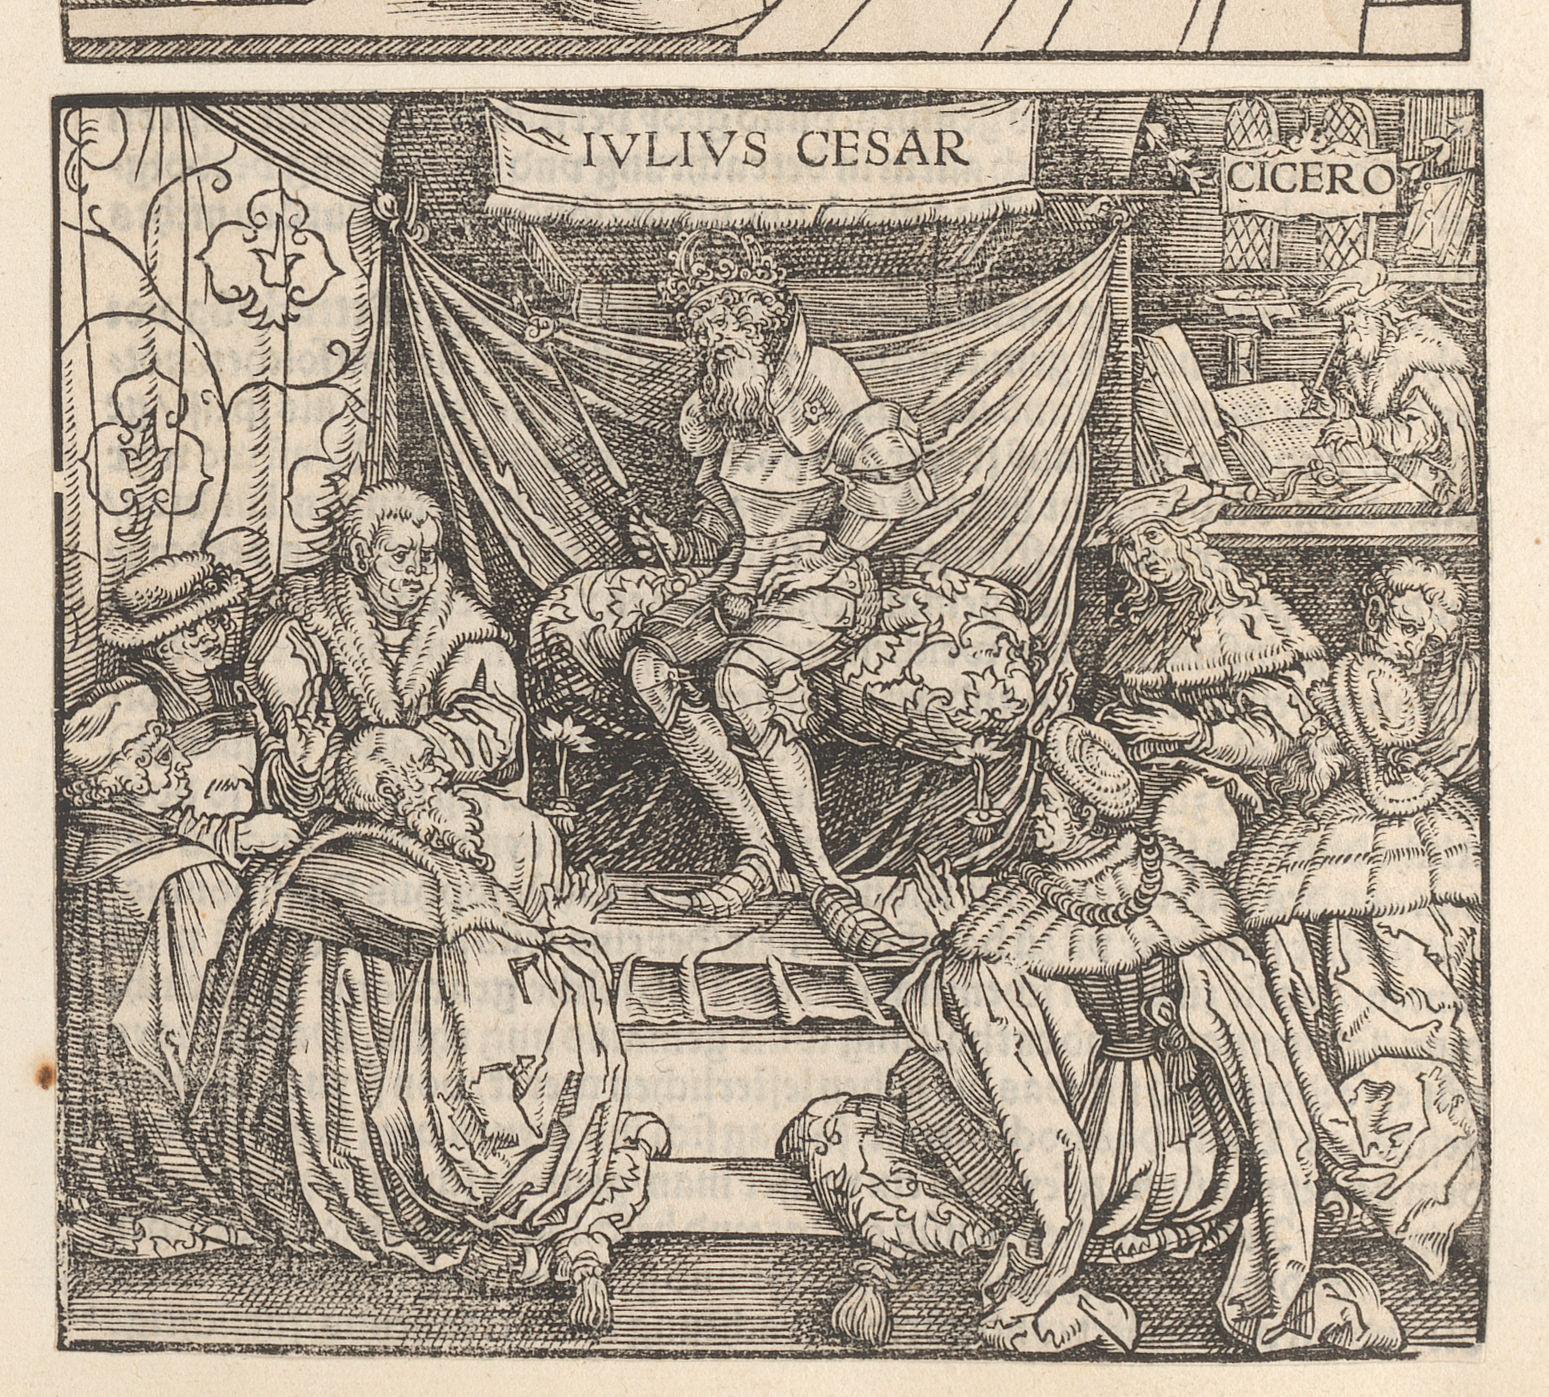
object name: print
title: Julius Caesar in een raadsvergadering en Cicero schrijvend achteraan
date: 1514-1531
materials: paper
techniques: letterpress printing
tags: (story of) cicero, counsellor, (story of) c. julius caesar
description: Deze prent is gebruikt in: Cicero, Marcus Tulius. Officia M.T.C. Ein Buch so Marcus Tullius Cicero der Römer zu seynem (...). [Vertaald uit het Latijn door] Johann von Schwarzenberg. Augsburg: Heinrich Steiner, 1531.